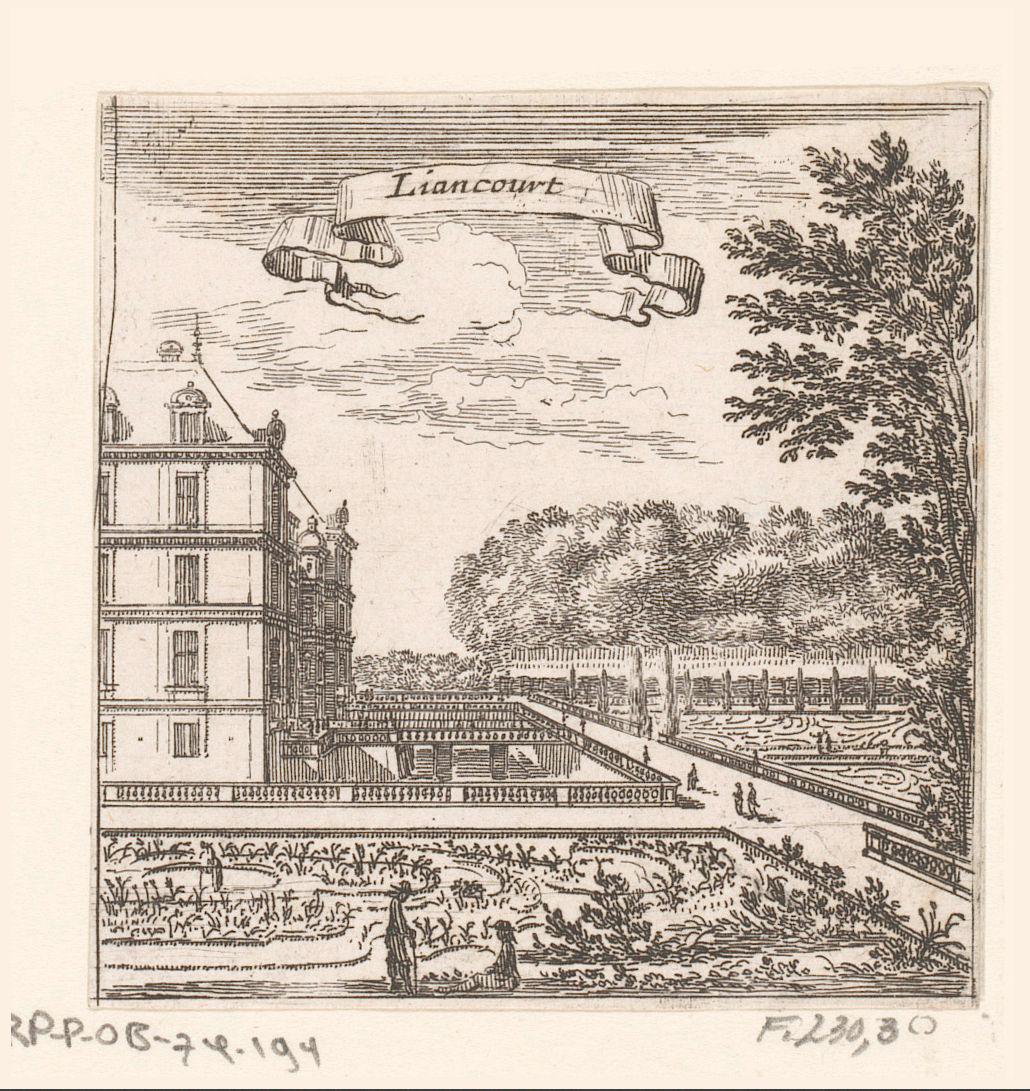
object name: print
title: Kleine gezichten op het kasteel en de tuinen van Rochefoucauld in Liancourt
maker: israël silvestre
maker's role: draughtsman, print maker, publisher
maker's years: 1621-1691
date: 1655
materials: paper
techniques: engraving, etching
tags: french or architectonic garden; formal garden, landscape with tower or castle, paris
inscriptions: collector's mark: Lugt 240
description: Prent maakt deel uit van een ongenummerde serie van tien prenten.